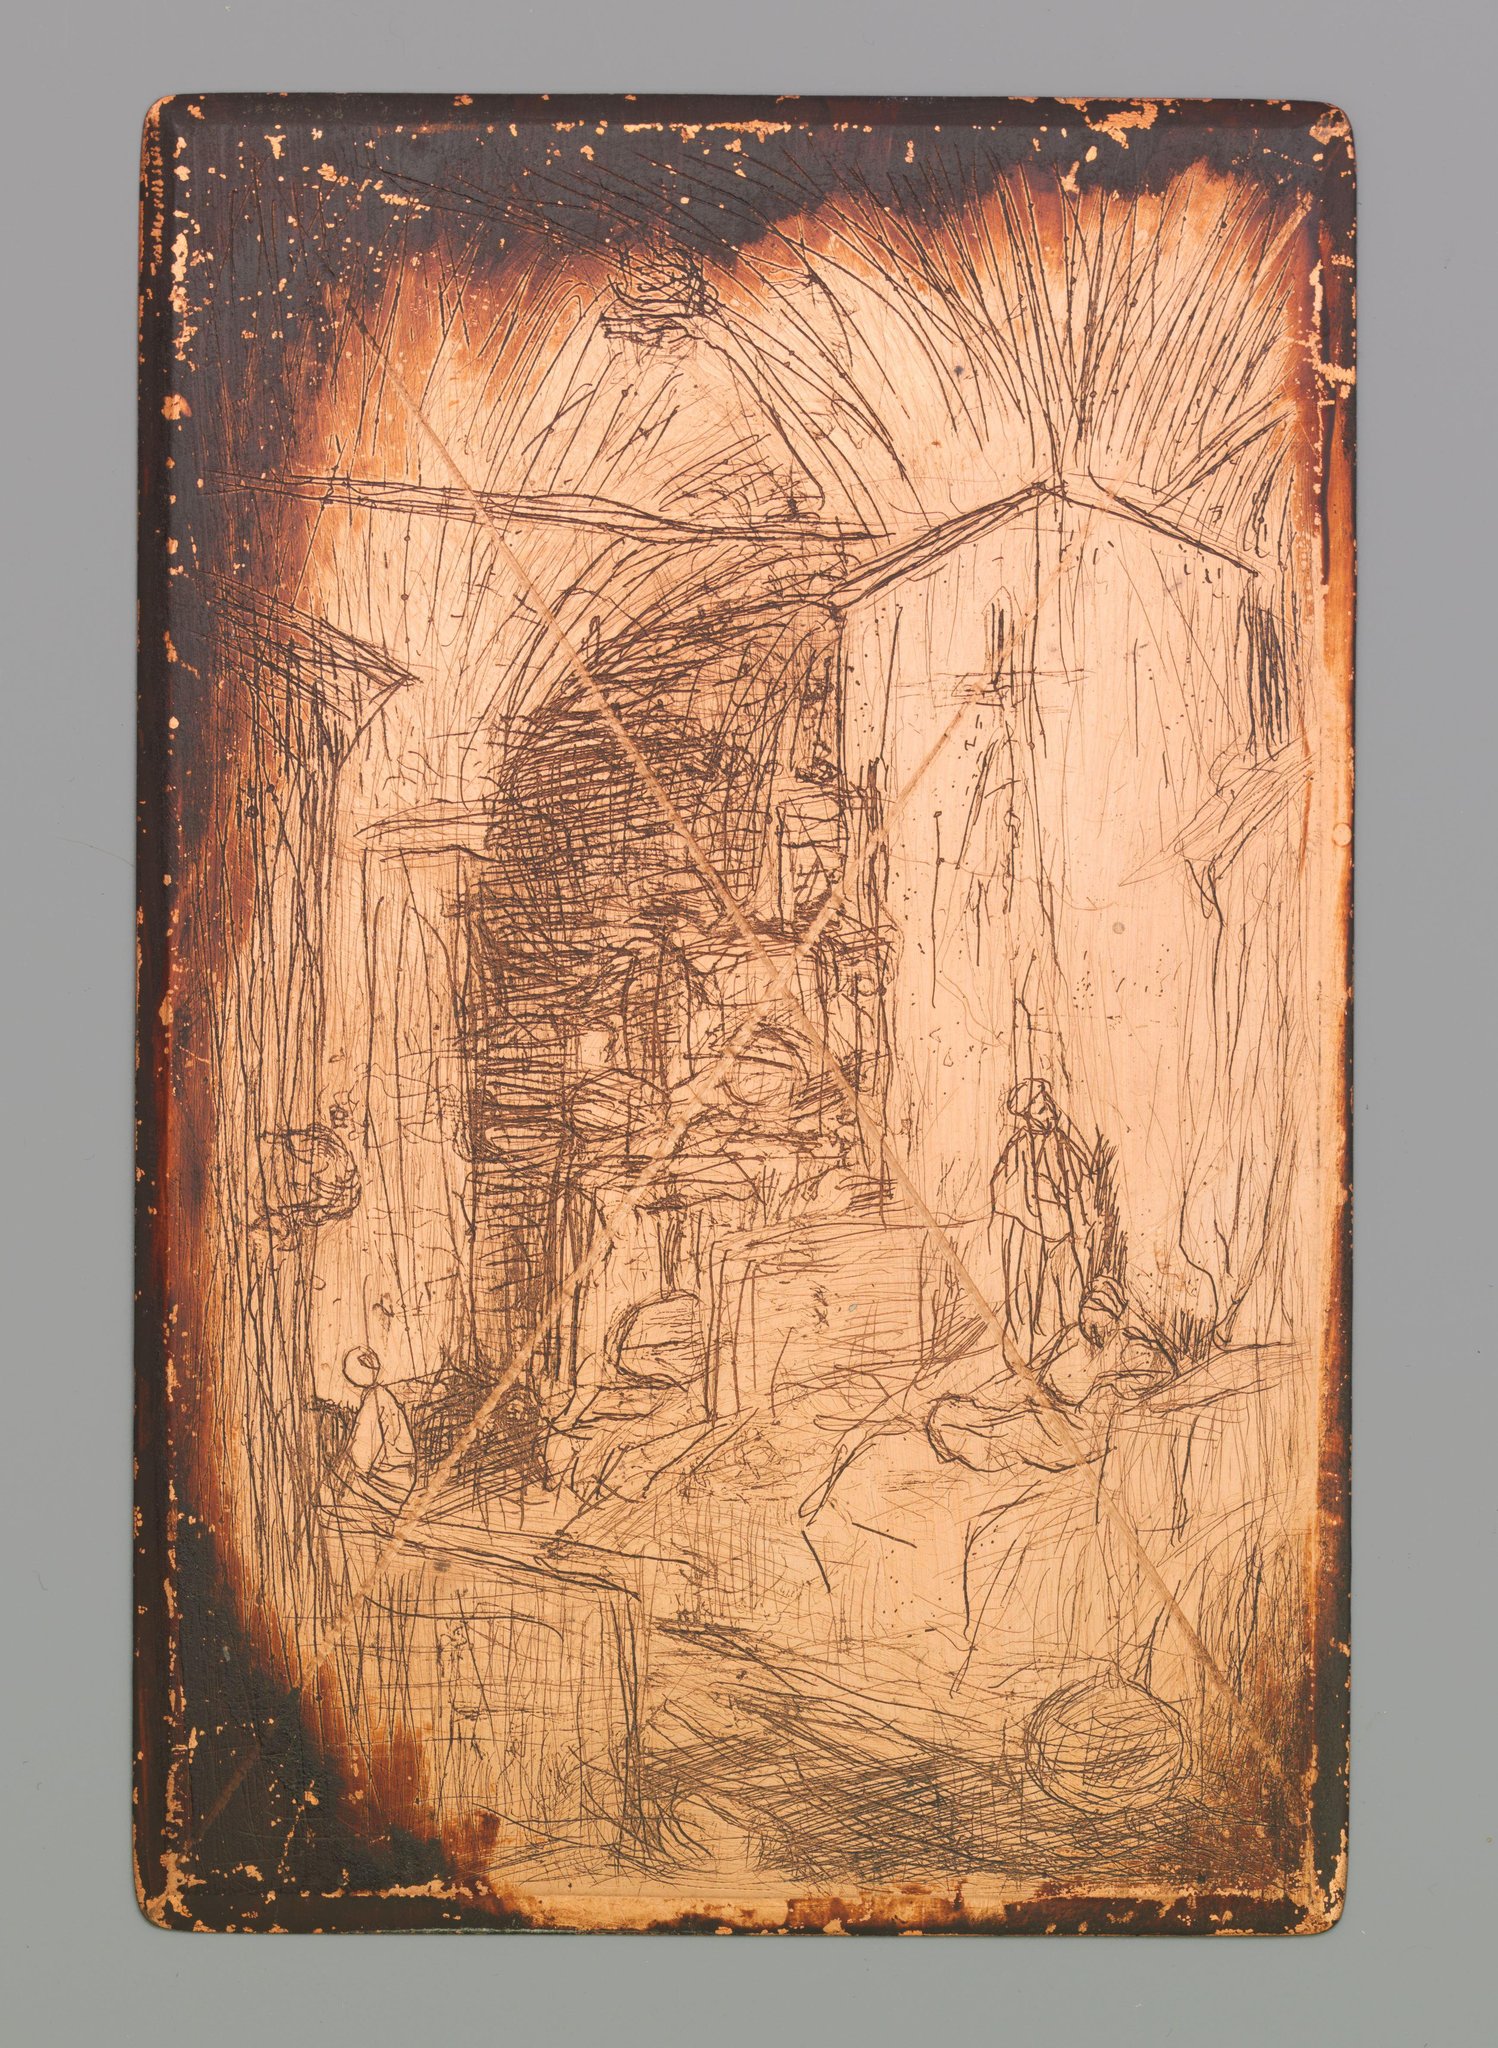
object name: copper plate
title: Een Turkse bazaar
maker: marius bauer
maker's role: draughtsman, print maker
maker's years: 1867-1932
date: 1924-1932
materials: copper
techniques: etching